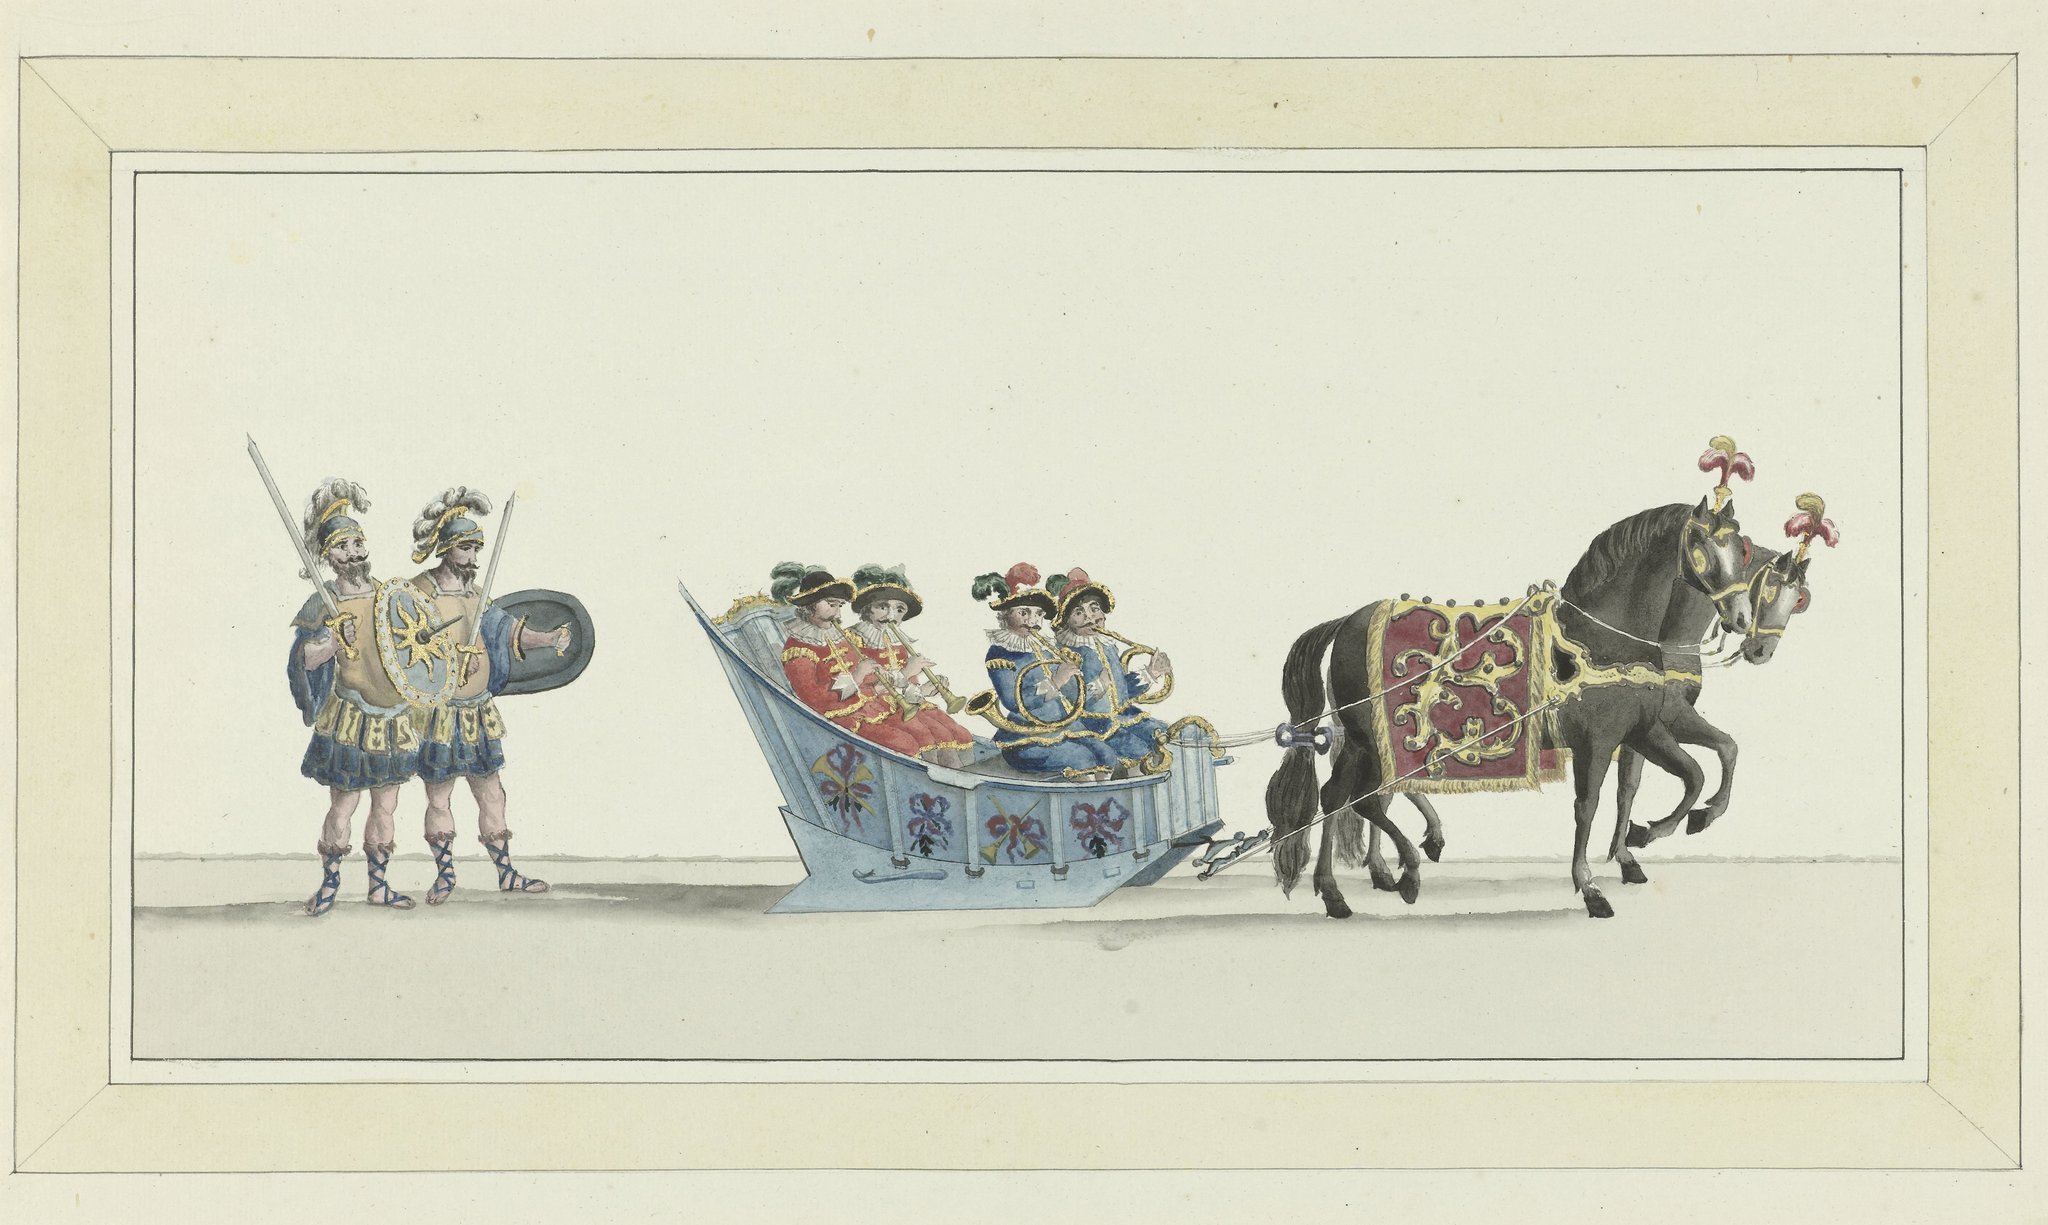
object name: drawing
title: Sledevaart van het Leidse genootschap Veniam Pro Laude in 1776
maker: abraham delfos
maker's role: draughtsman, painter, print maker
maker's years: 1731-1820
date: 1776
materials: paper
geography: northern netherlands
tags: sledge, sleigh (winter sports), commemoration of the founding of a university, leiden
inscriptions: collector's mark: Lugt 2228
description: De tweede slede in de optocht. Een grote slede met vier muzikanten getrokken door twee paarden en gevolgd door twee Romeinen met zwaarden. Onderdeel van de reeks van vijftien tekeningen voor de platen van de sledevaart op 24 januari 1776 georganiseerd door het Leidse genootschap Veniam Pro Laude bij gelegenheid van het Tweede Eeuwfeest van het Leids Ontzet (3 oktober 1574) en de oprichting van de Universiteit van Leiden (8 februari 1575).